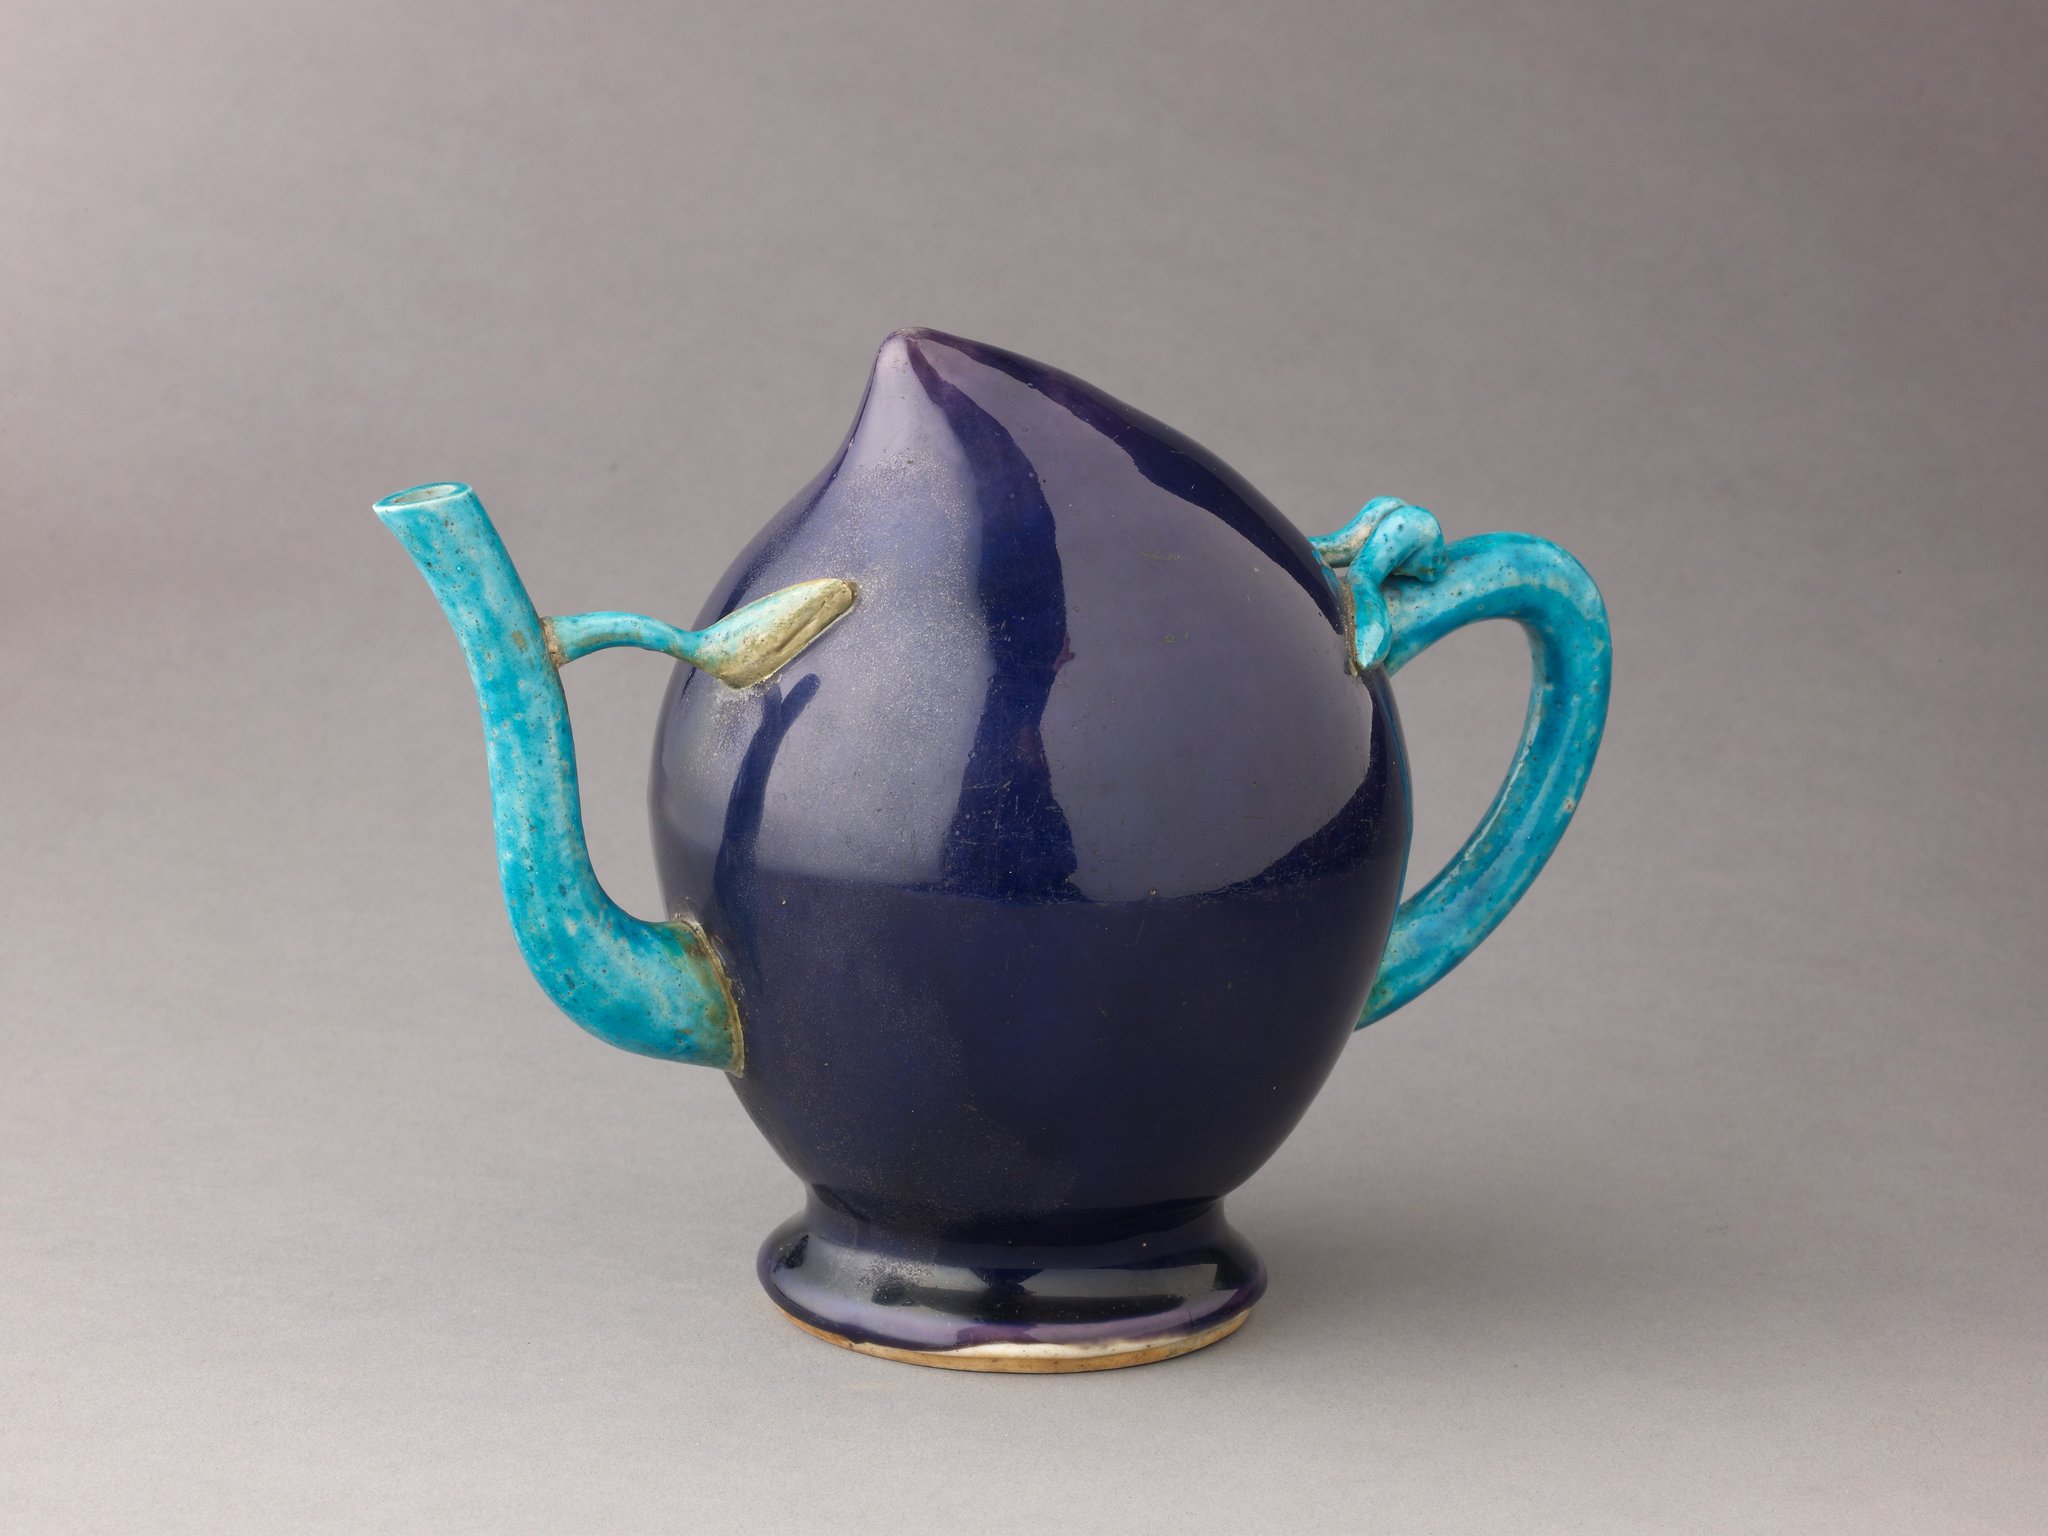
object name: winepot or teapot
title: Peach-shaped wine pot or teapot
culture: chinese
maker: chinese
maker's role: artist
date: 1701-1800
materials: glaze, porcelain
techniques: polychrome, relief